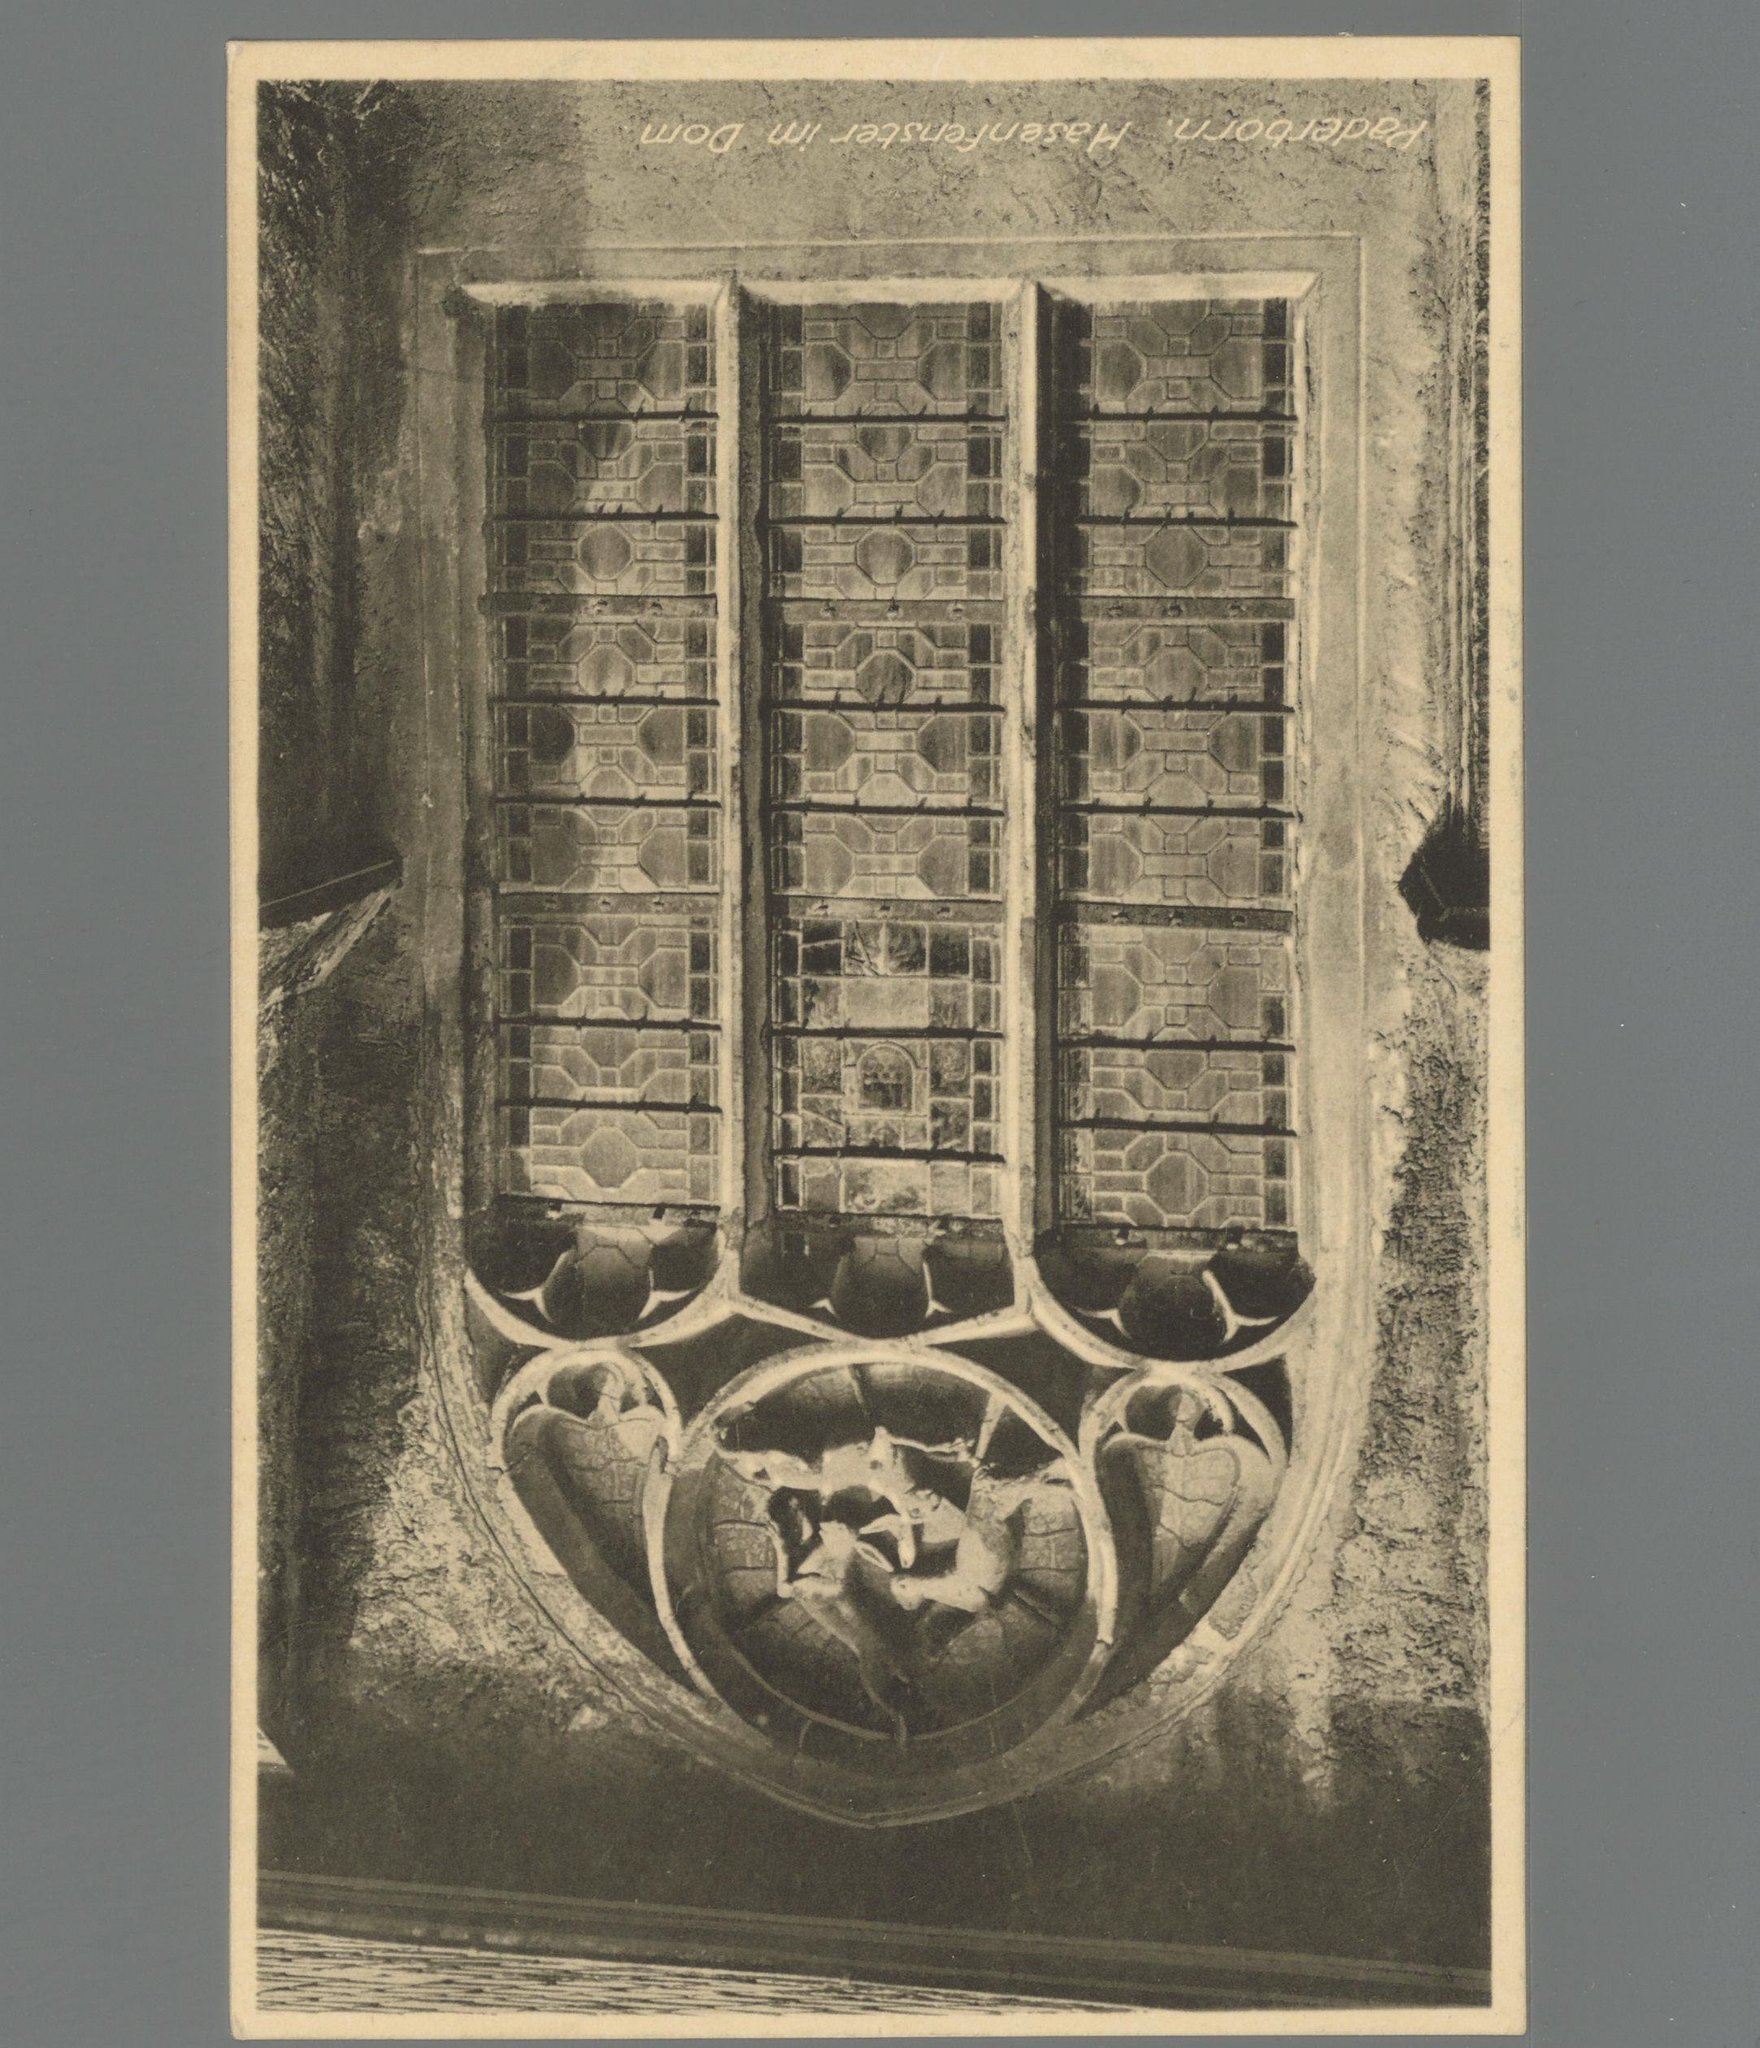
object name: photomechanical print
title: Paderborn. Hasenfenster im Dom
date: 1905-1930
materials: cardboard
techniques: photograph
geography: paderborn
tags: church (exterior), closed window